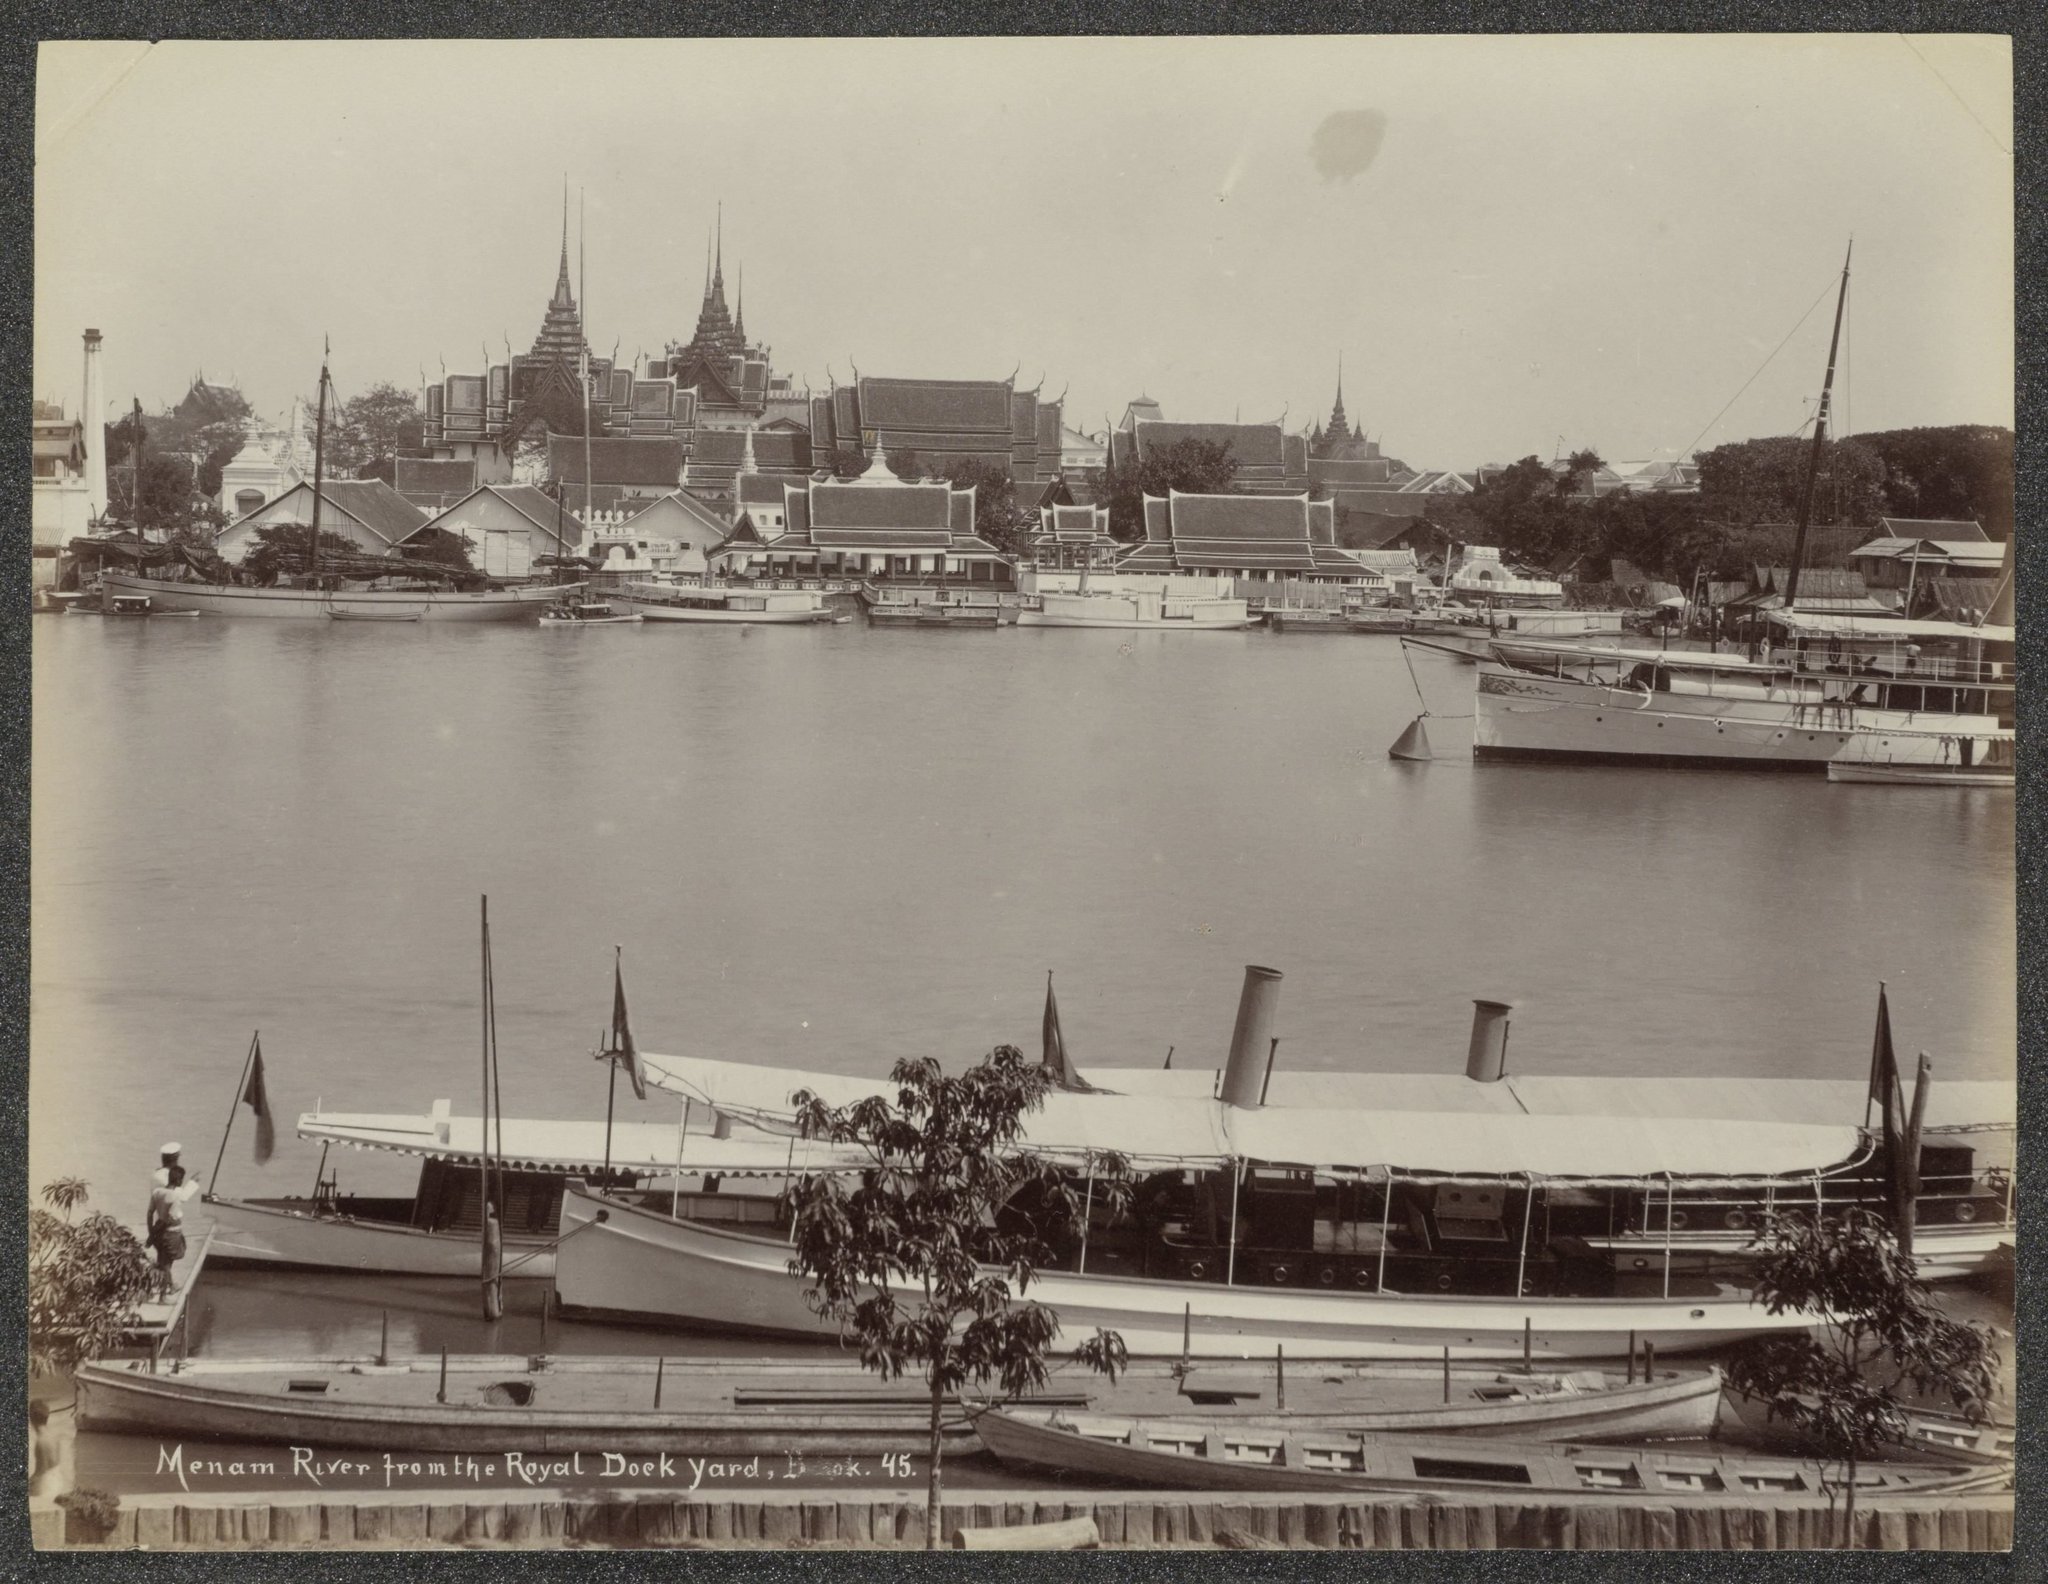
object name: photograph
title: Menam River from the Royal Dock Yard, B[(...)]ok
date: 1870-1900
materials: paper, photographic support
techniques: albumen print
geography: bangkok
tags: pier, quay, wharf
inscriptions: negative number: ‘45’, check stamp: ‘G.R. Lambert Singapore’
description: Onderdeel van Album met 50 foto's van een reis door Zuidoost-Azië.